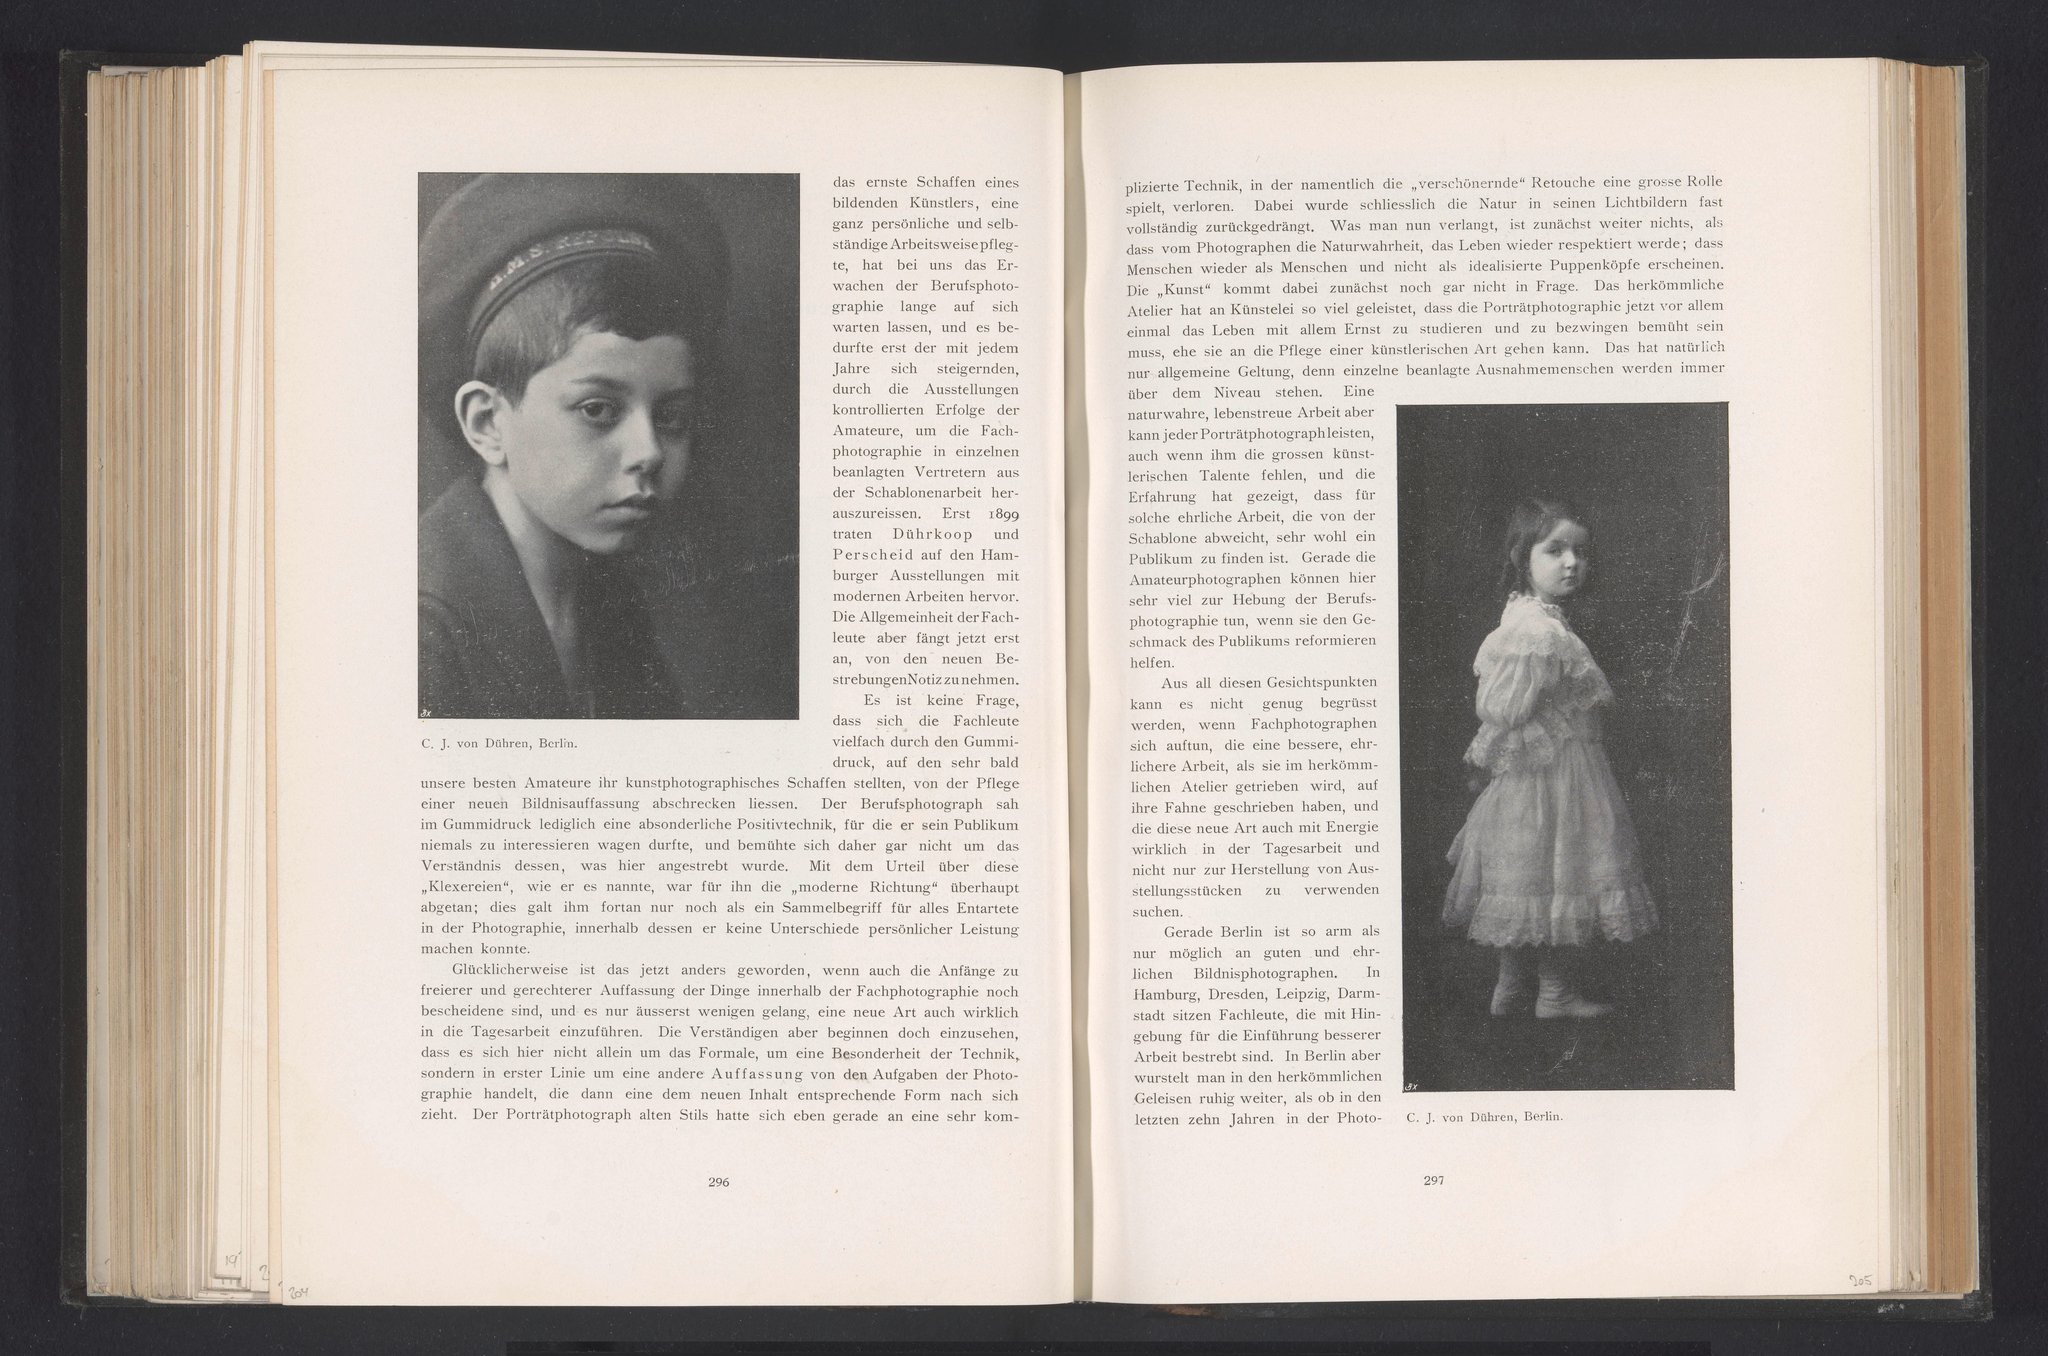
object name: page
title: Portret van een onbekende jongen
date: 1898-1903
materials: paper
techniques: autotype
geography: berlin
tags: historical persons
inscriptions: monogram: ‘BX’